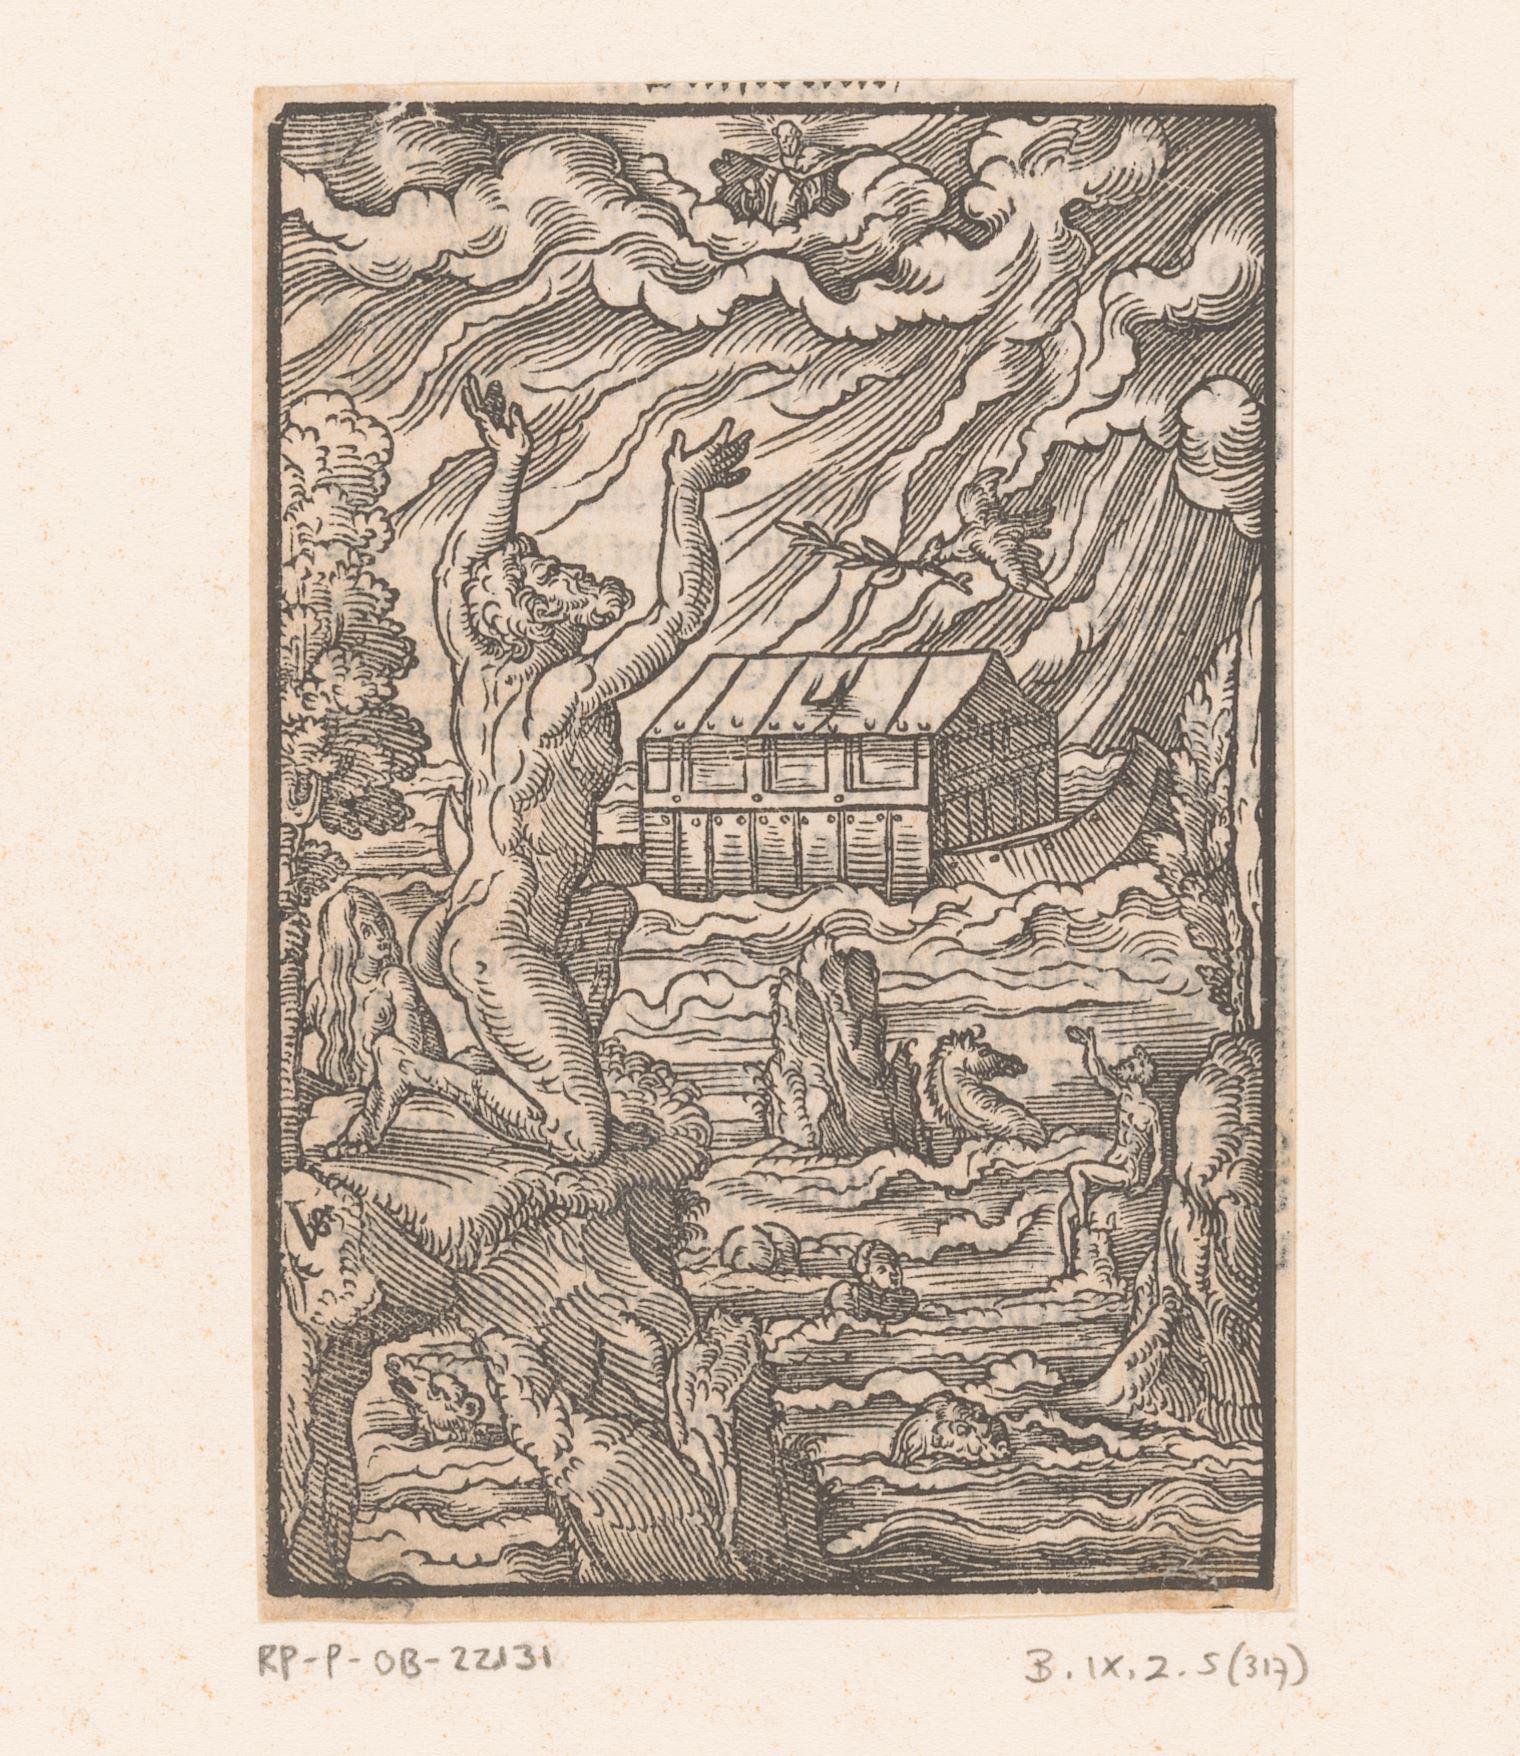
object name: book illustration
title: Zondvloed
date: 1552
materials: paper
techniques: woodcut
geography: nuremberg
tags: the ark is floating on the waters, while life on earth is destroyed ~ story of noah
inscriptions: number: ‘181’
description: Gebruikt voor verschillende publicaties die werden gedrukt door Valentin Geißler tussen 1552 en 1560 te Neurenberg.